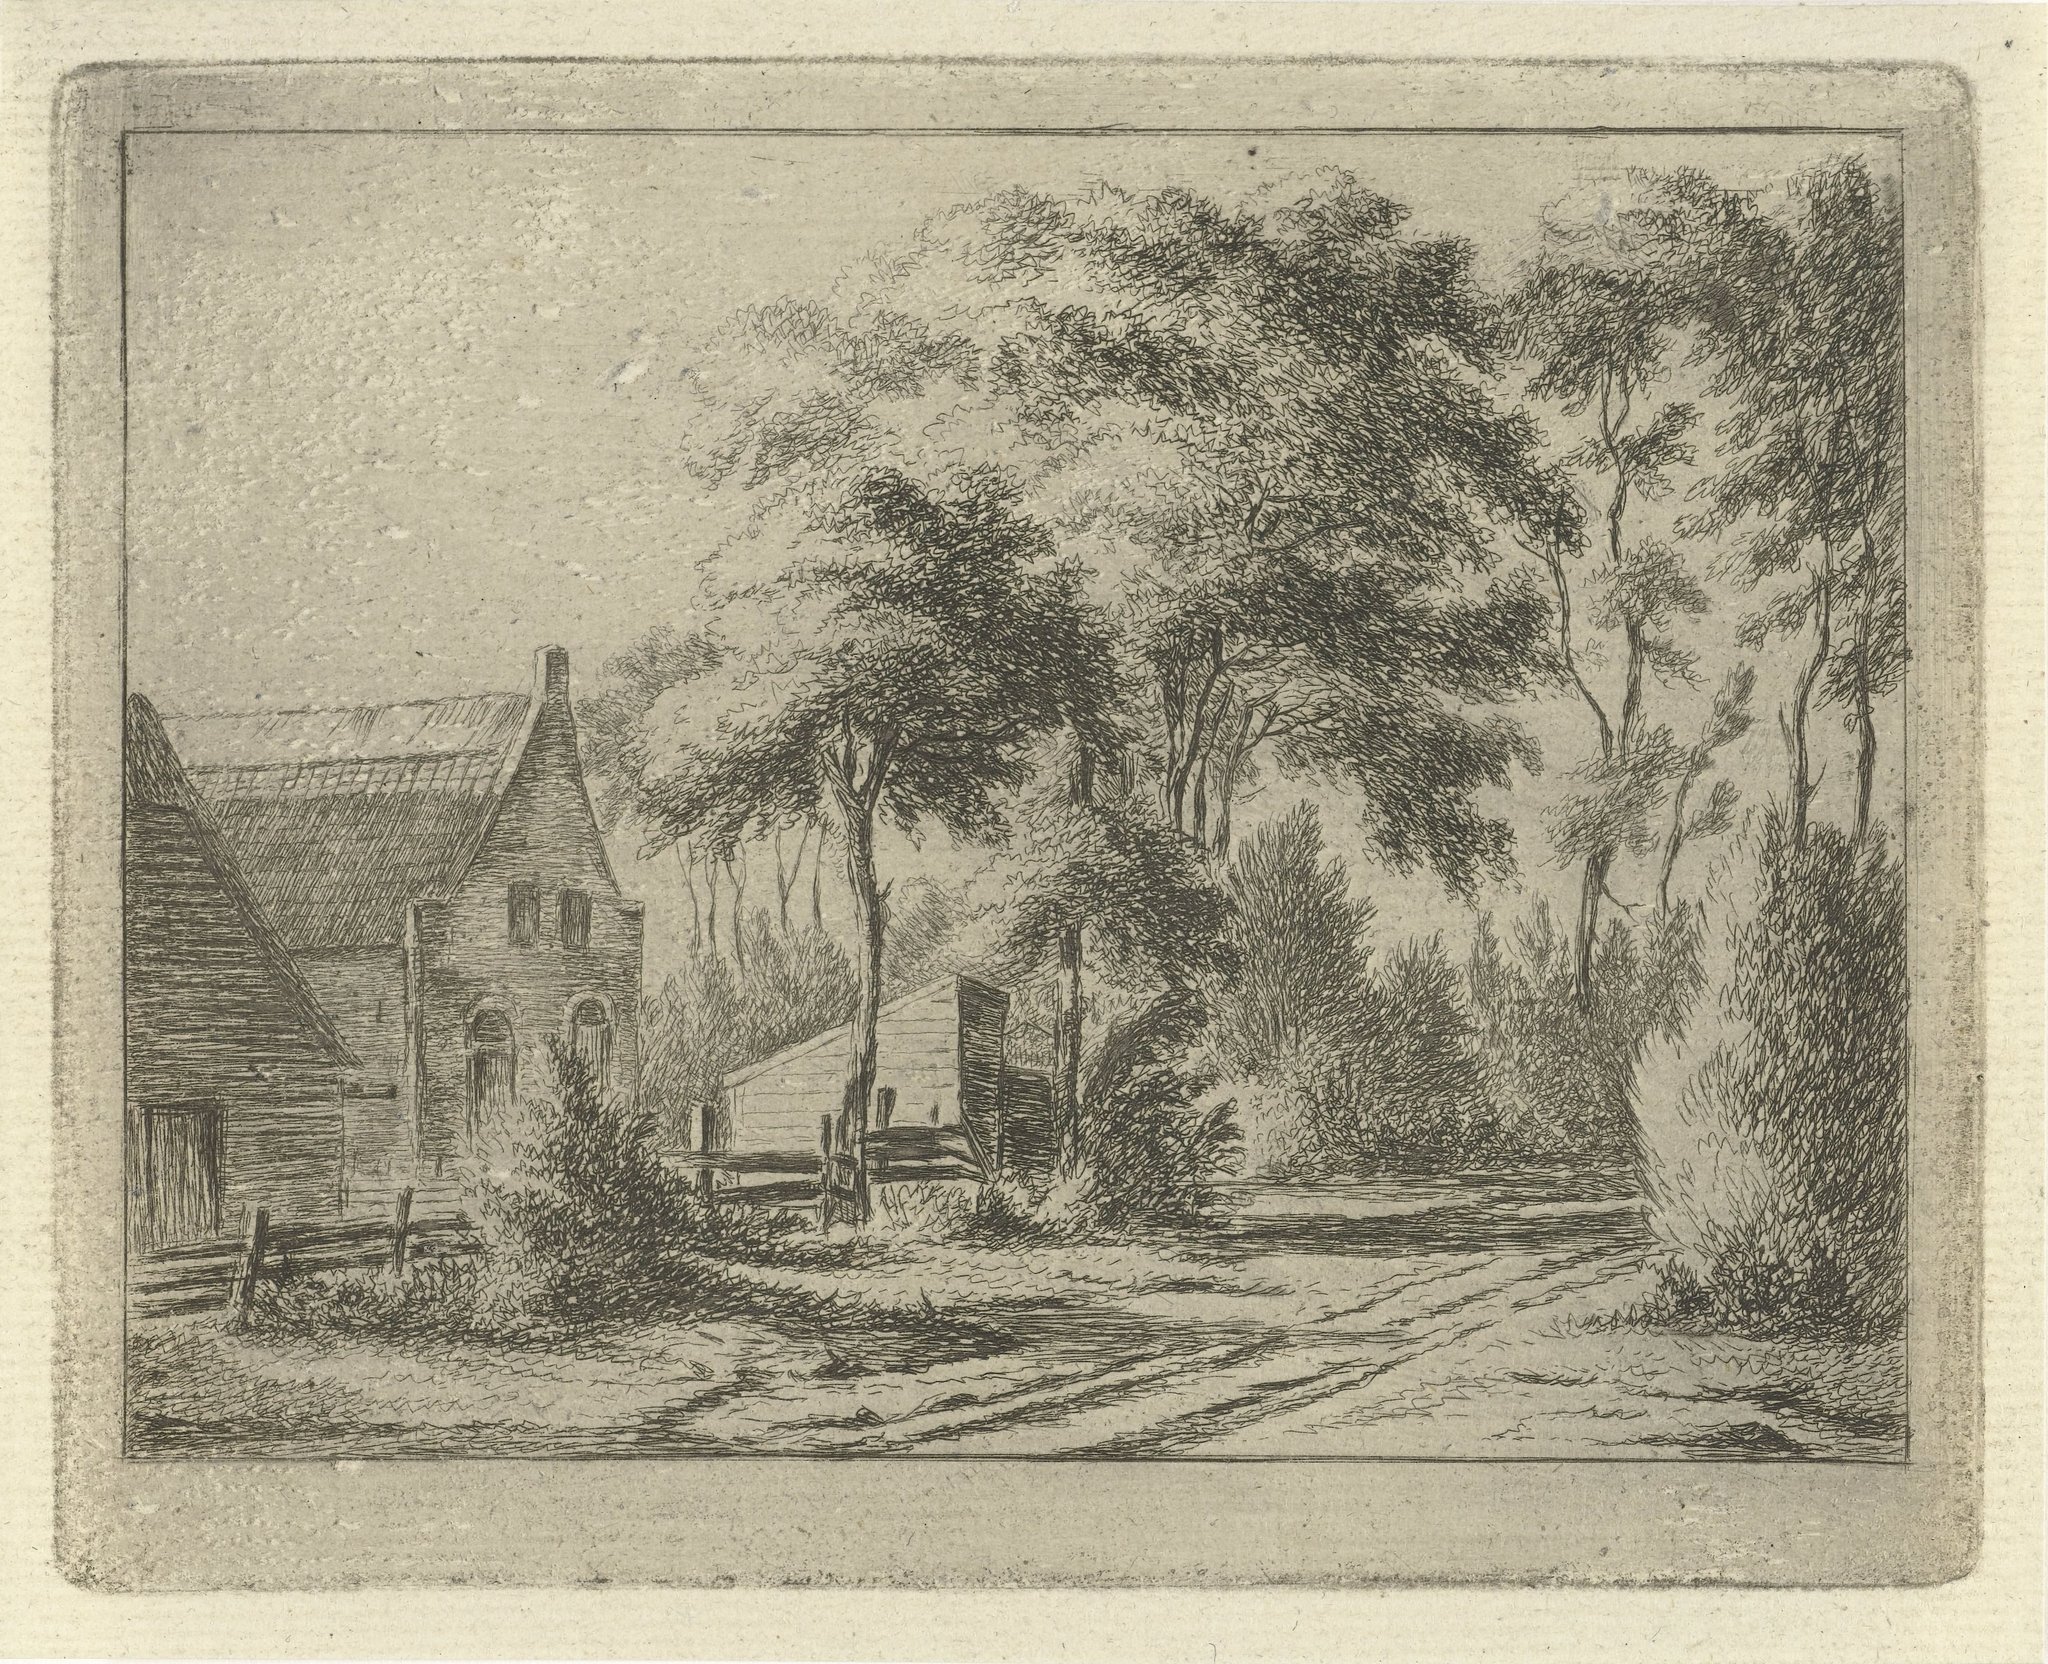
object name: print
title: Landweg bij een boerderij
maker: jacobus cornelis gaal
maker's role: print maker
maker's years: 1796-1866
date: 1854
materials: paper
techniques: etching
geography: netherlands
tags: village lane, alley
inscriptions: collector's mark: Lugt 2228